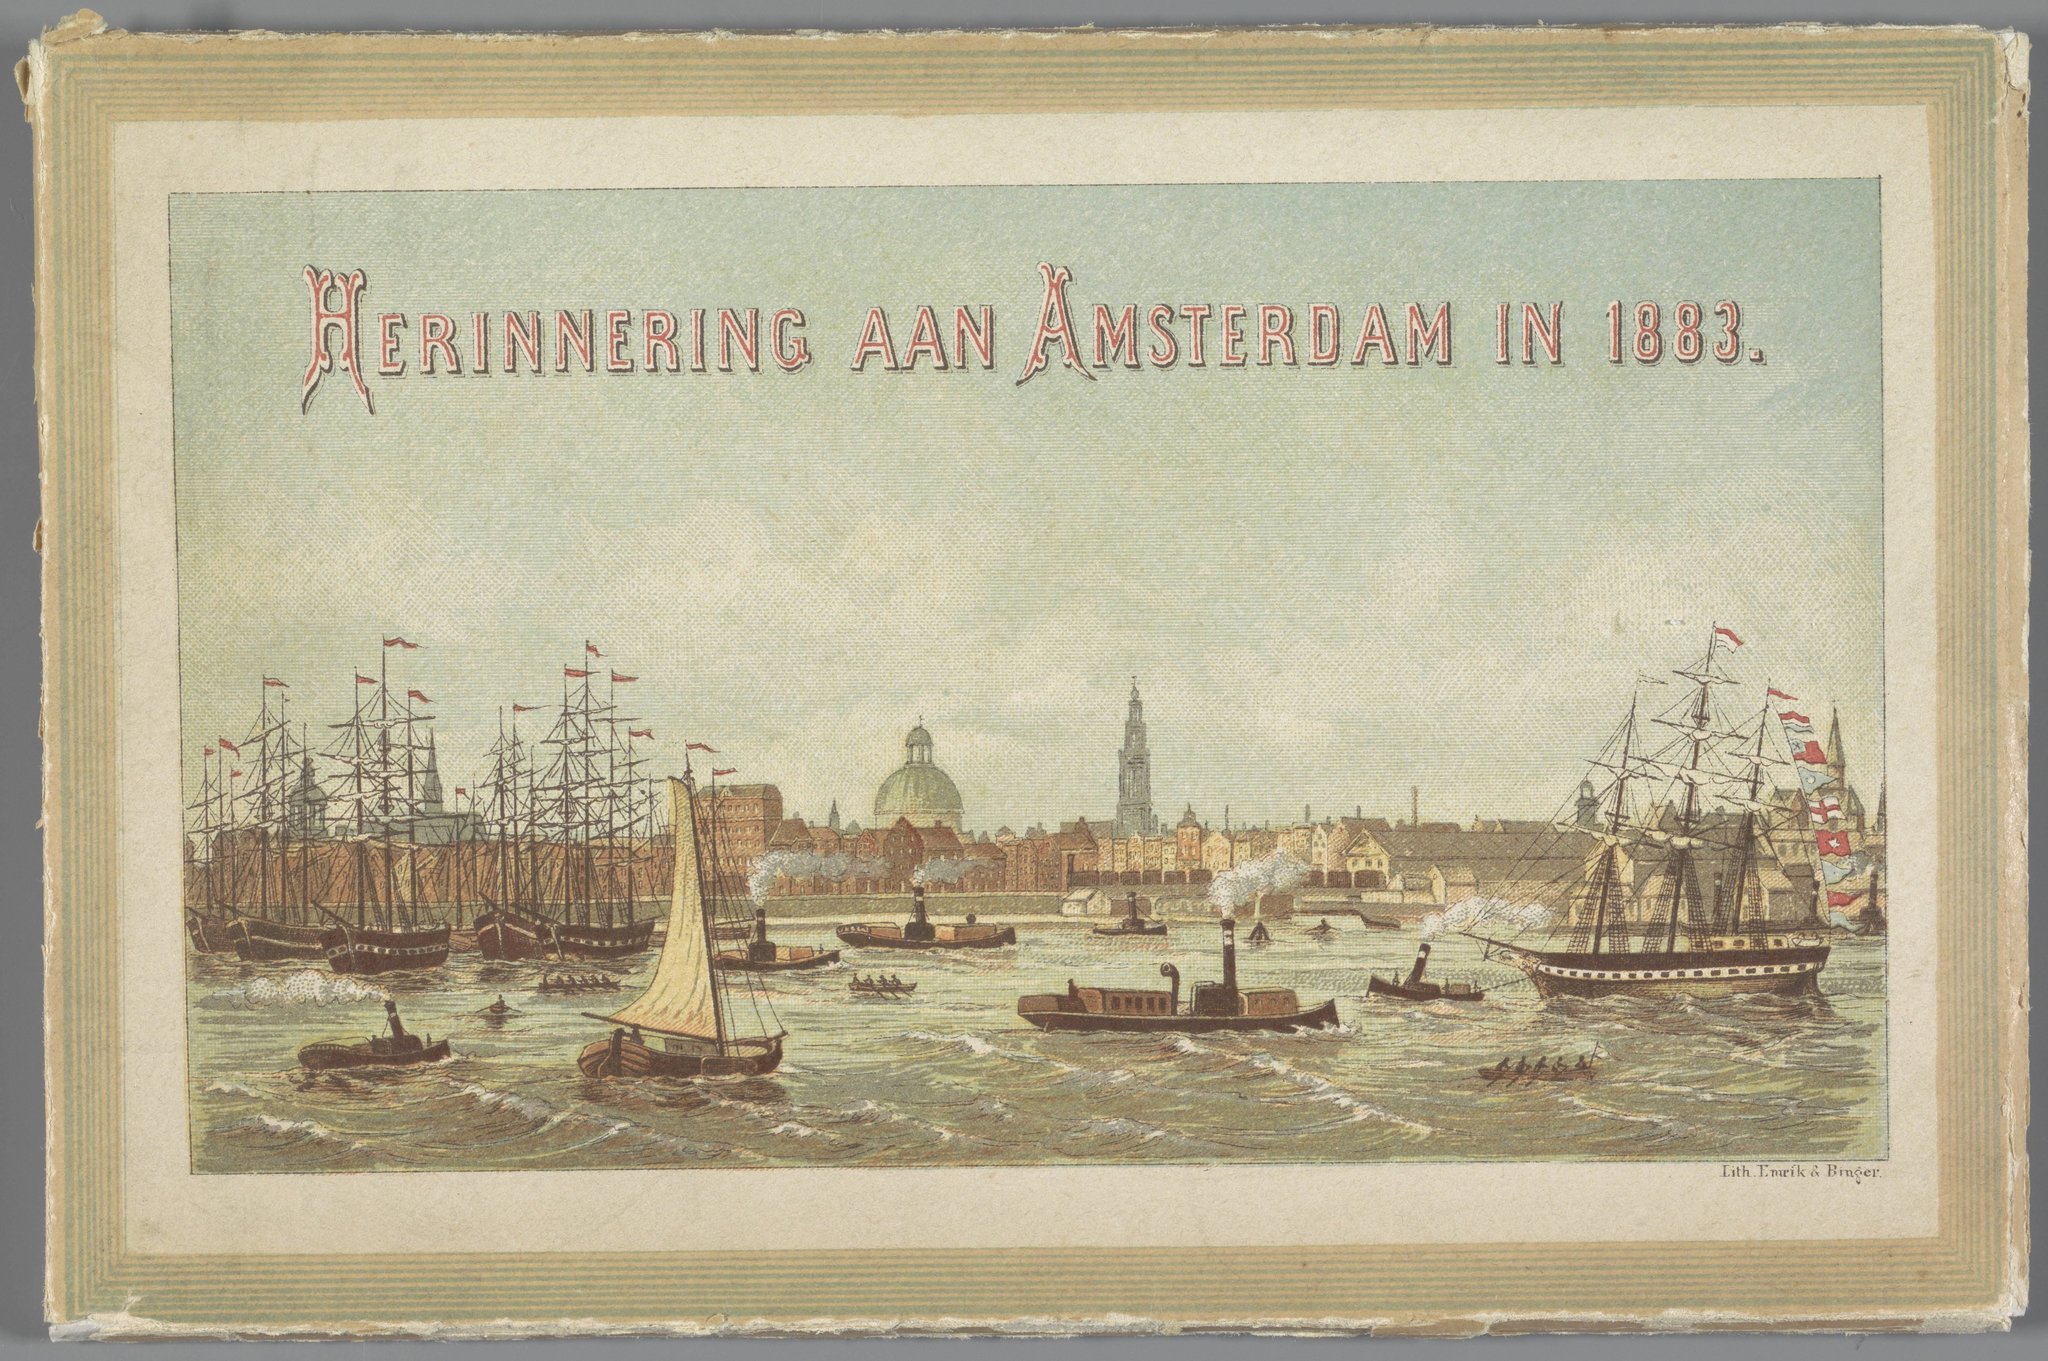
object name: print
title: Herinnering aan Amsterdam in 1883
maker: Anonymous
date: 1883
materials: paper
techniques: chromolithography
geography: netherlands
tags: world fair, world exhibition, amsterdam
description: Omslag met een gezicht op schepen op het IJ voor Amsterdam. Envelop voor een groep van zestien platen en een plattegrond van de Wereldtentoonstelling in Amsterdam van 1 mei tot 1 oktober 1883. Uitgave van het Nieuws van den Dag.